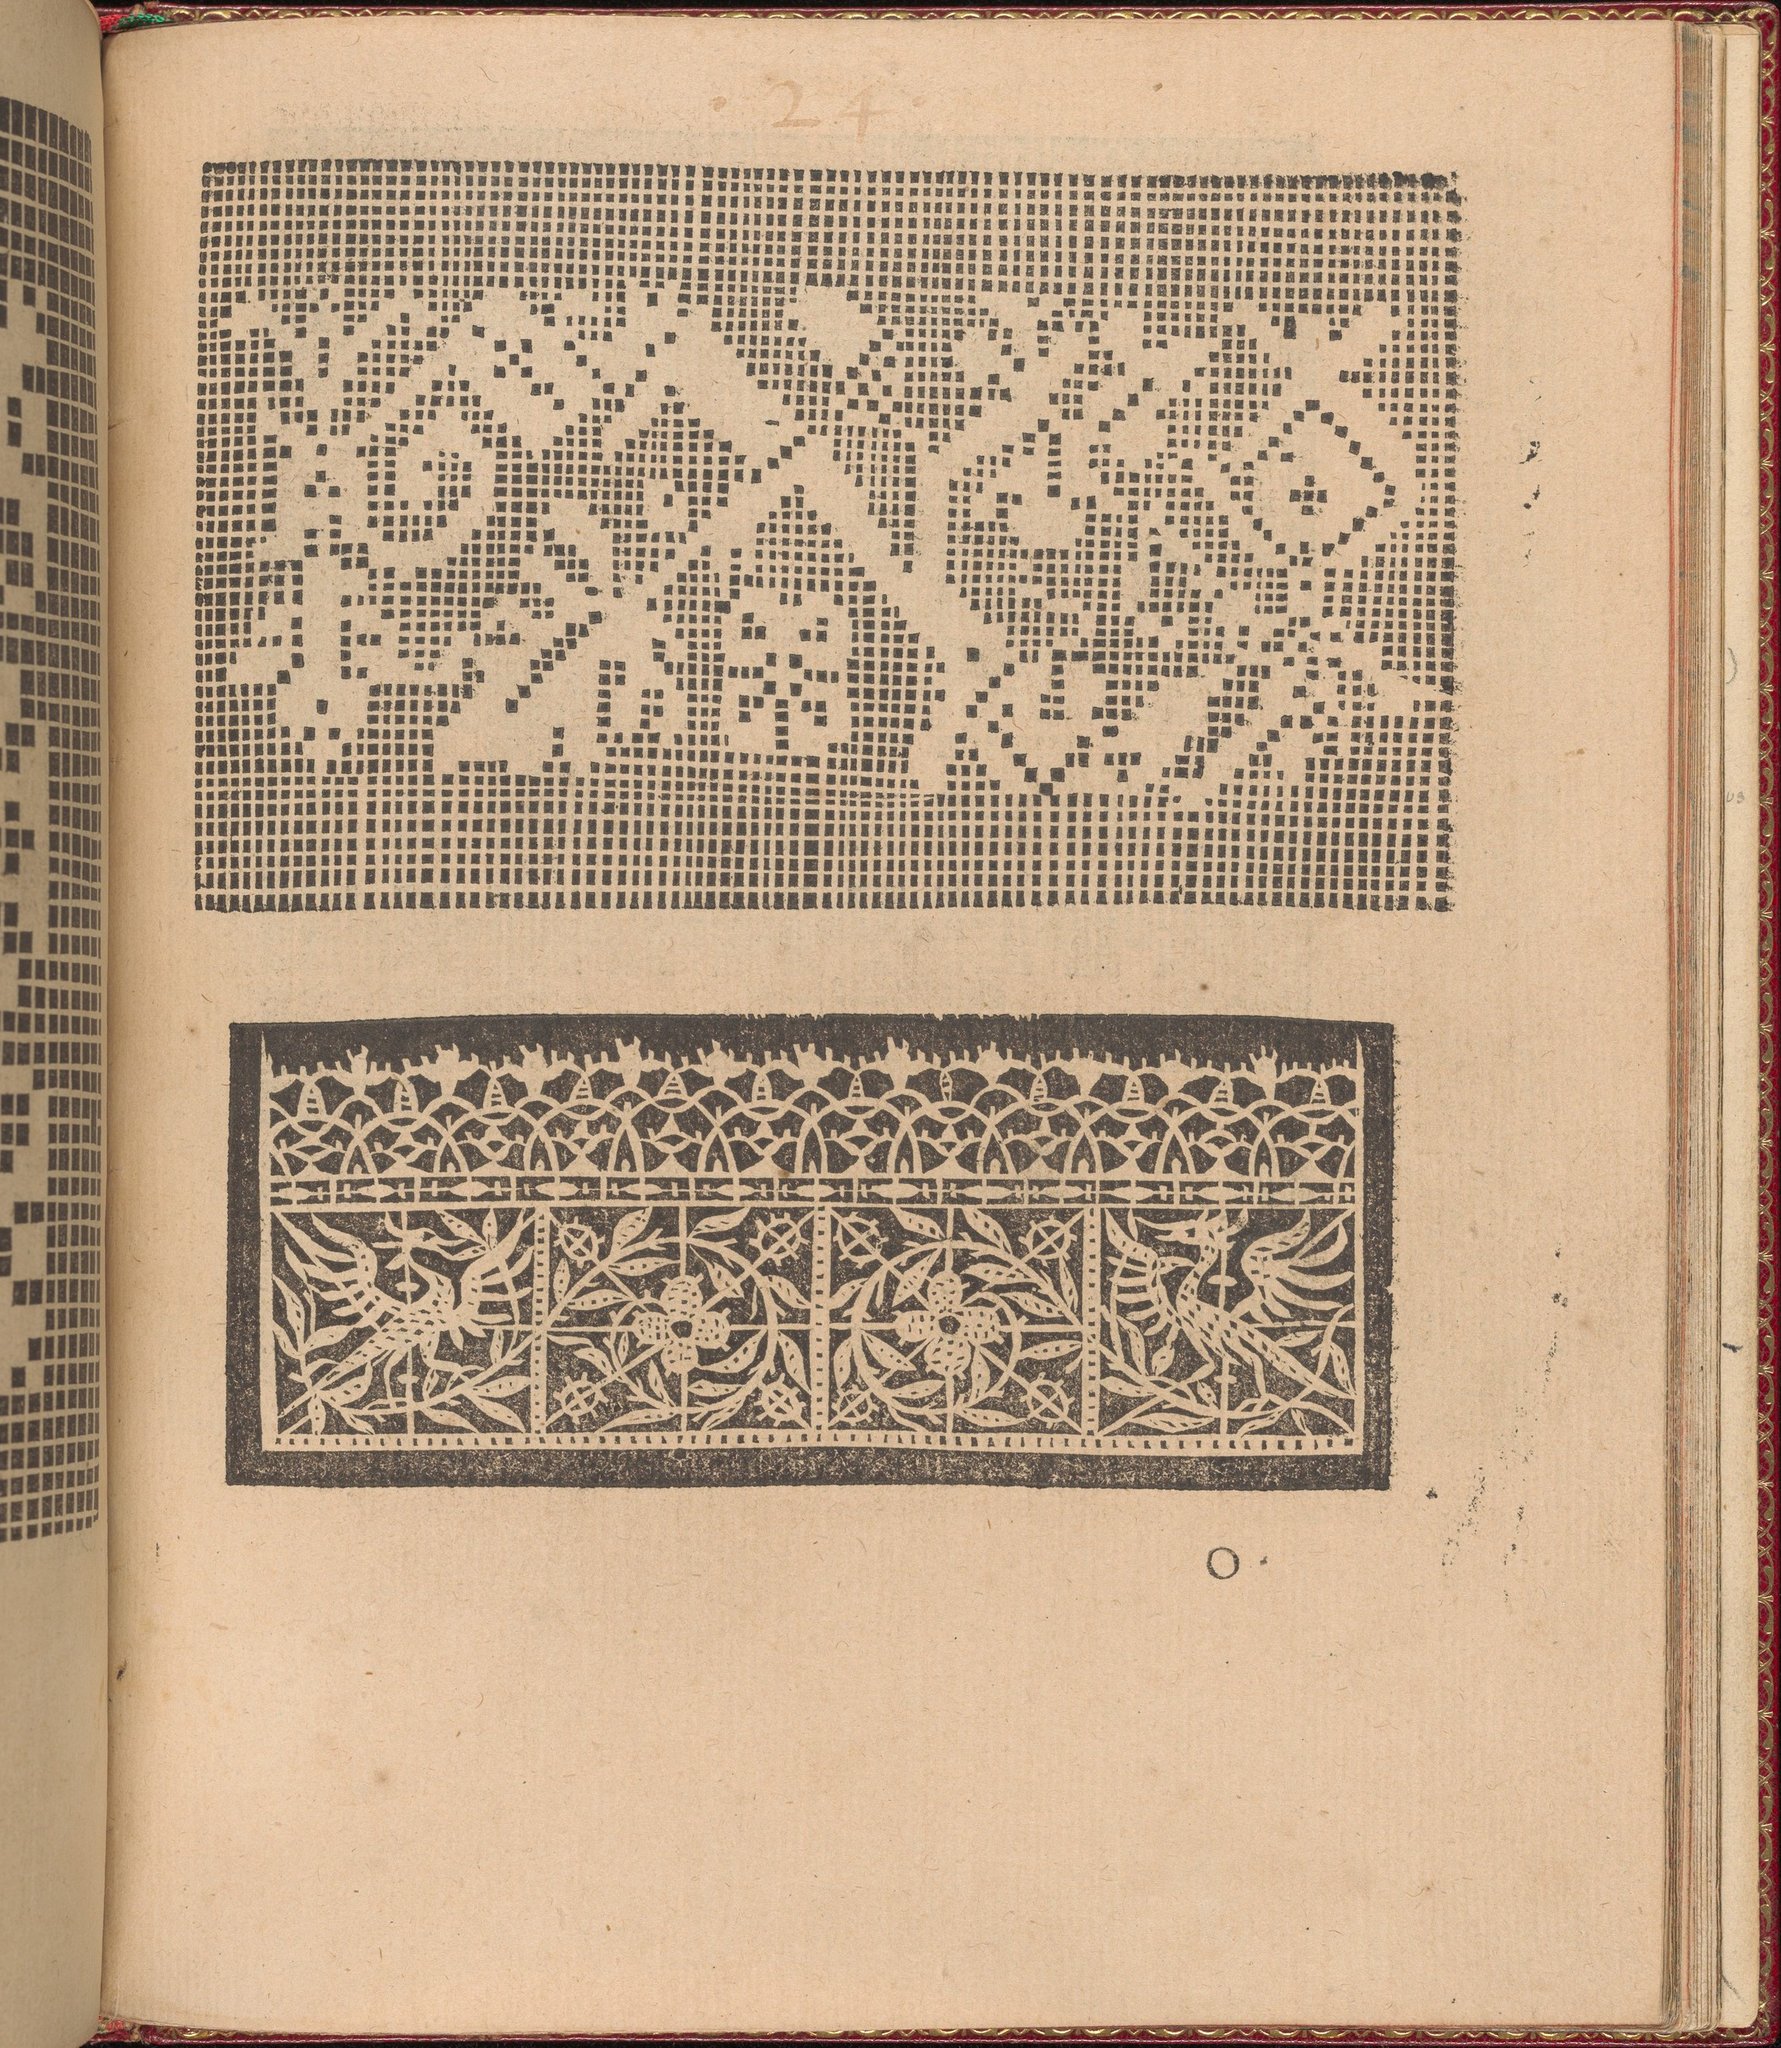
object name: book print ornament architecture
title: Les Singuliers et Nouveaux Portraicts... page 53 (recto)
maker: federico de vinciolo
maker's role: designer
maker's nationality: italian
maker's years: 1582-1599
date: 1588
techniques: woodcut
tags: birds,flowers